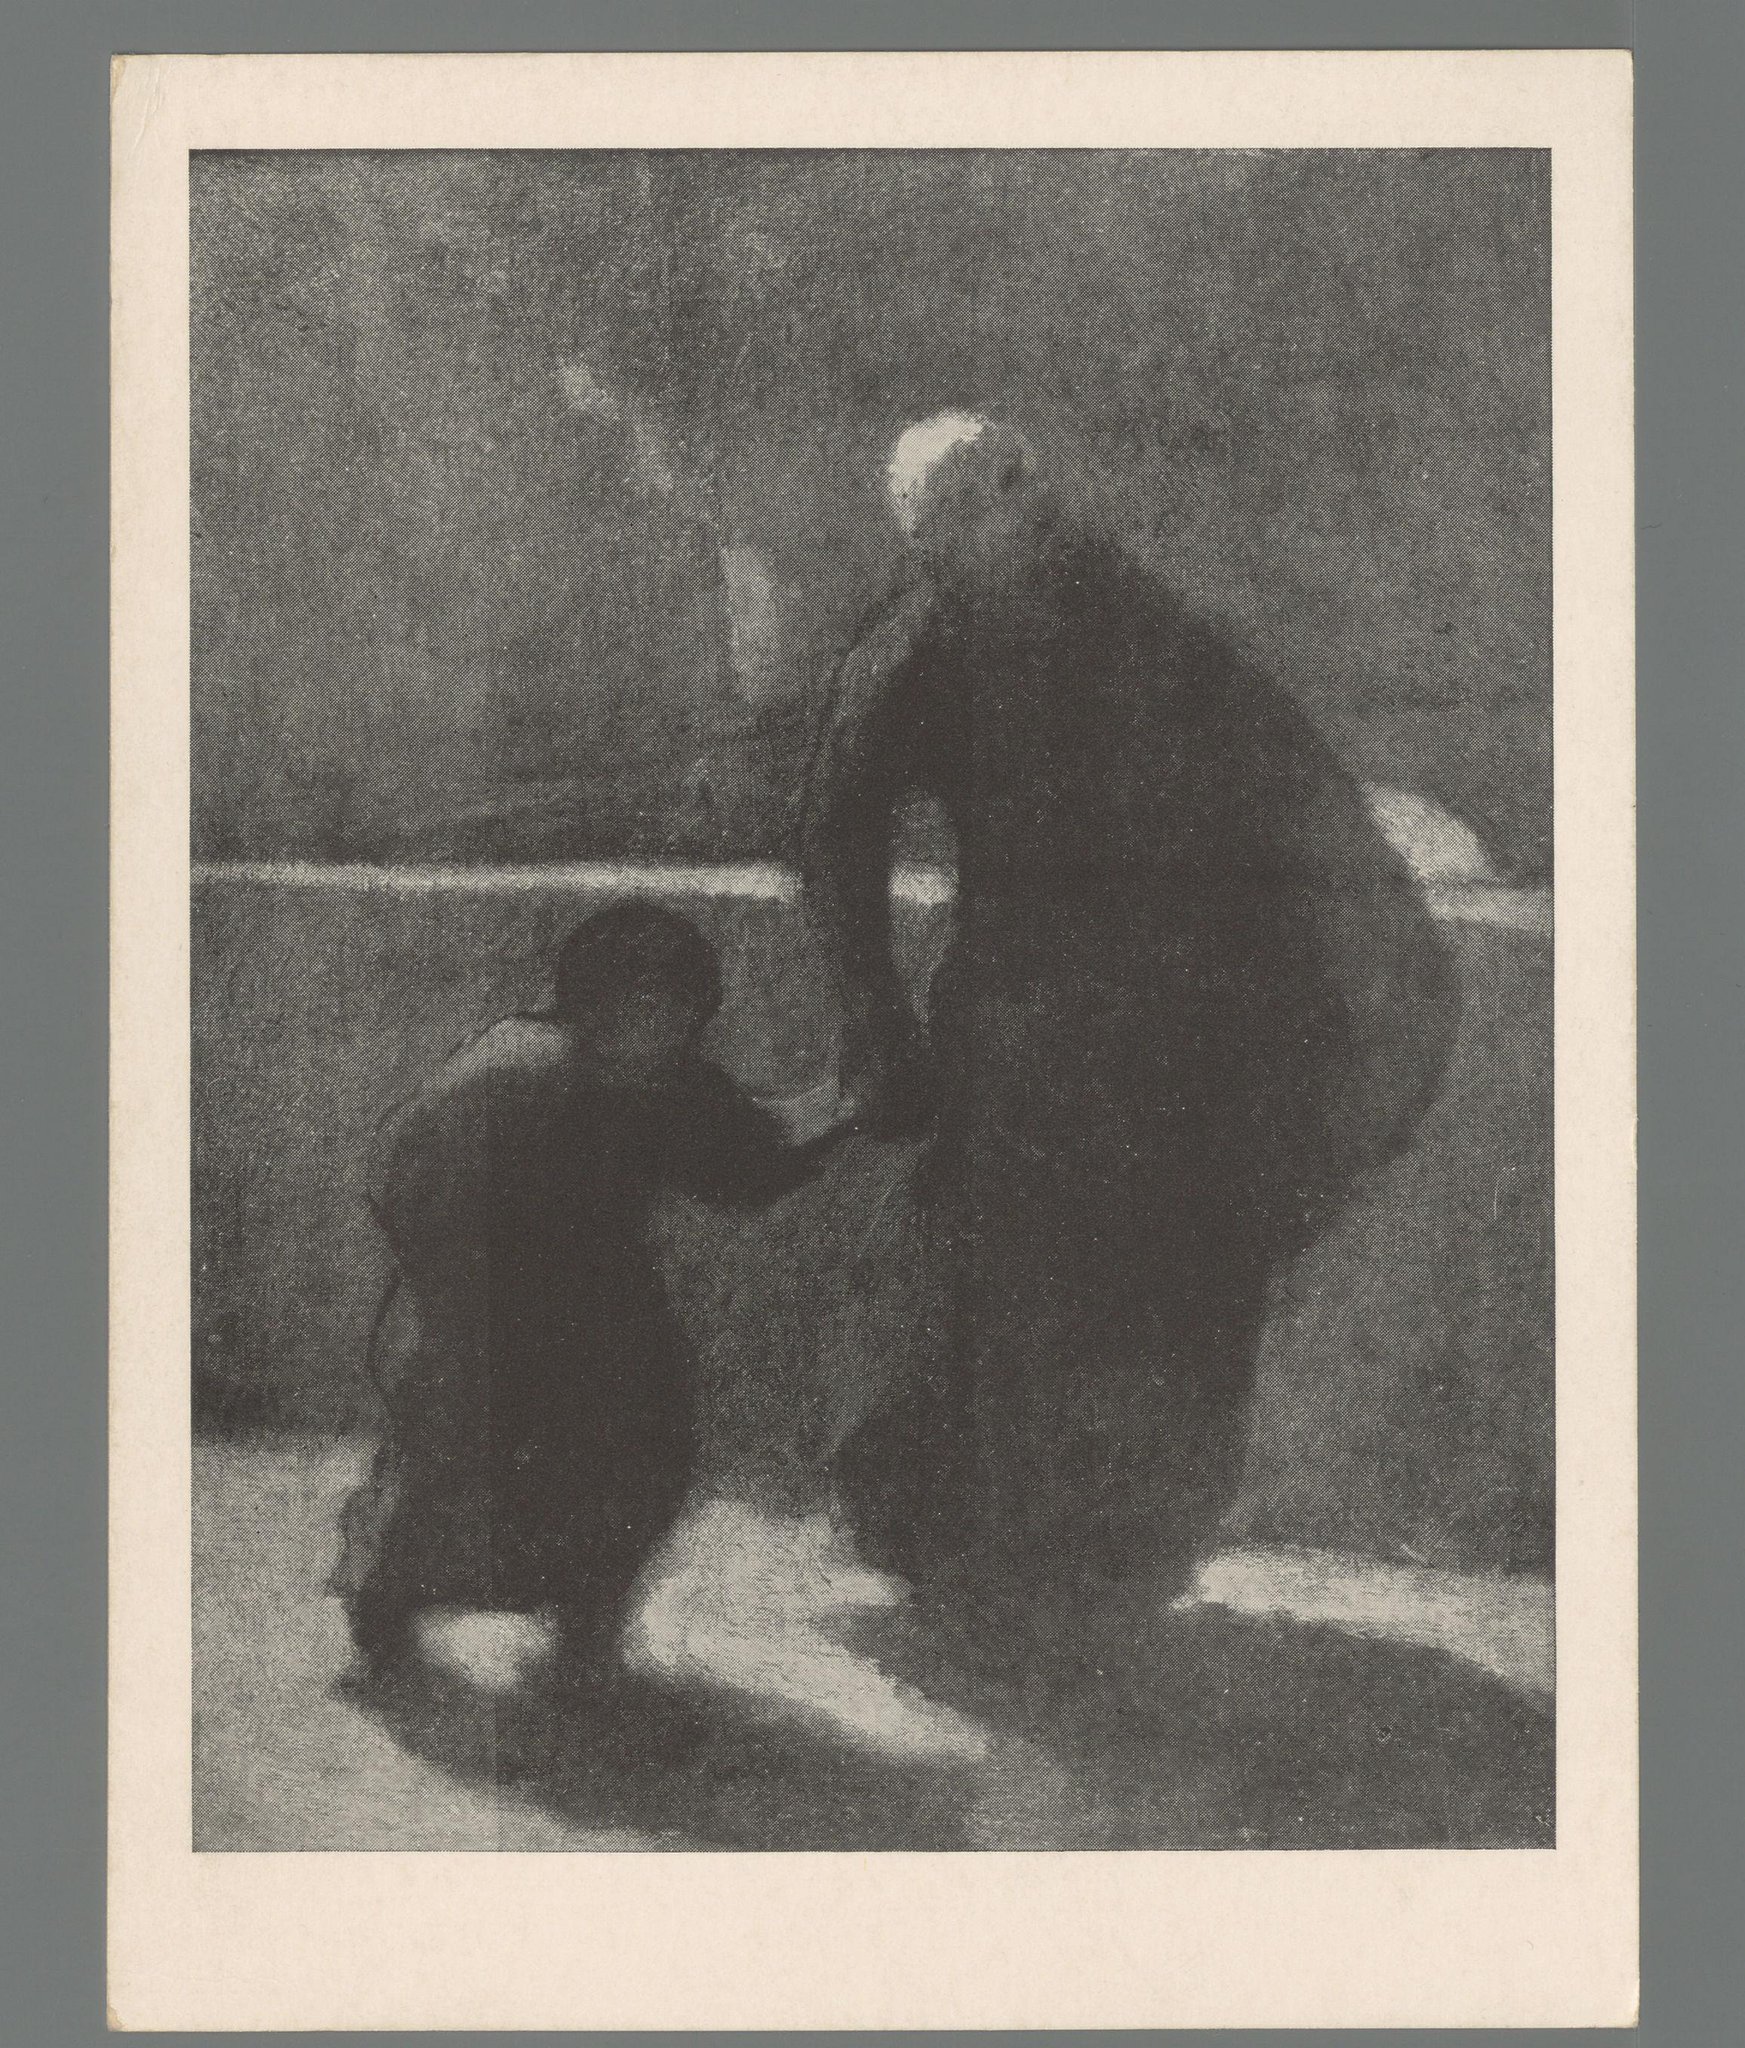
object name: photomechanical print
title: On a Bridge at Night by Daumier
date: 1922-1948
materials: cardboard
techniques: autotype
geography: washington d.c.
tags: adult woman, child, bridge in city across river, canal, etc.